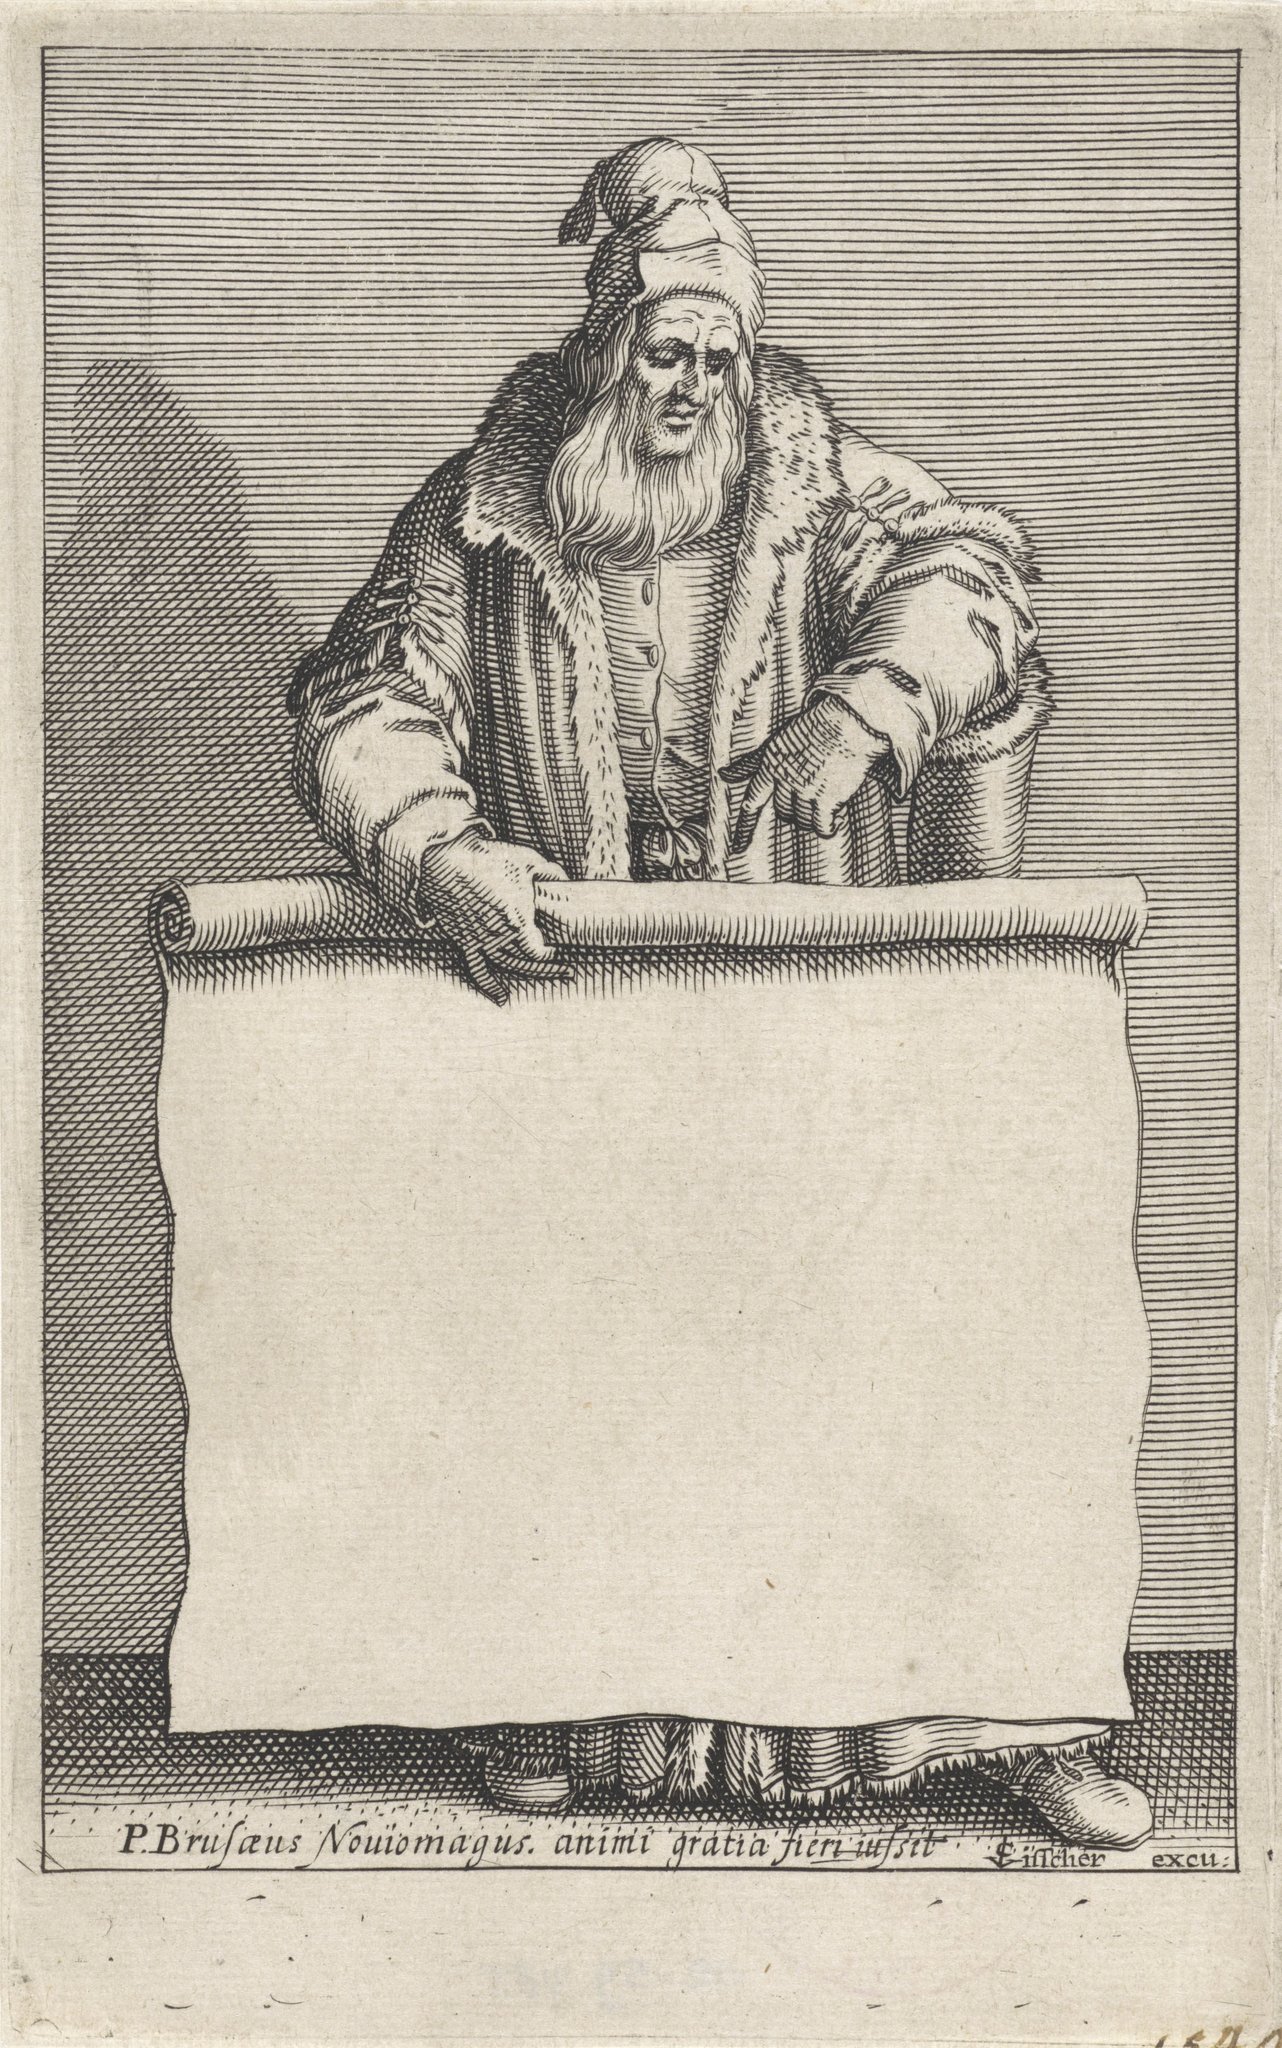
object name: print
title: Oude man met rol papier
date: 1601-1657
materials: paper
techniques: engraving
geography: amsterdam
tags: scroll - ll - scroll unfolded, old man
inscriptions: collector's mark: Lugt 240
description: Oude man met baard en bontkraag met een uitgerolde boekrol in de hand. Hij wijst met zijn vinger op het onbeschreven schrijfvlak.